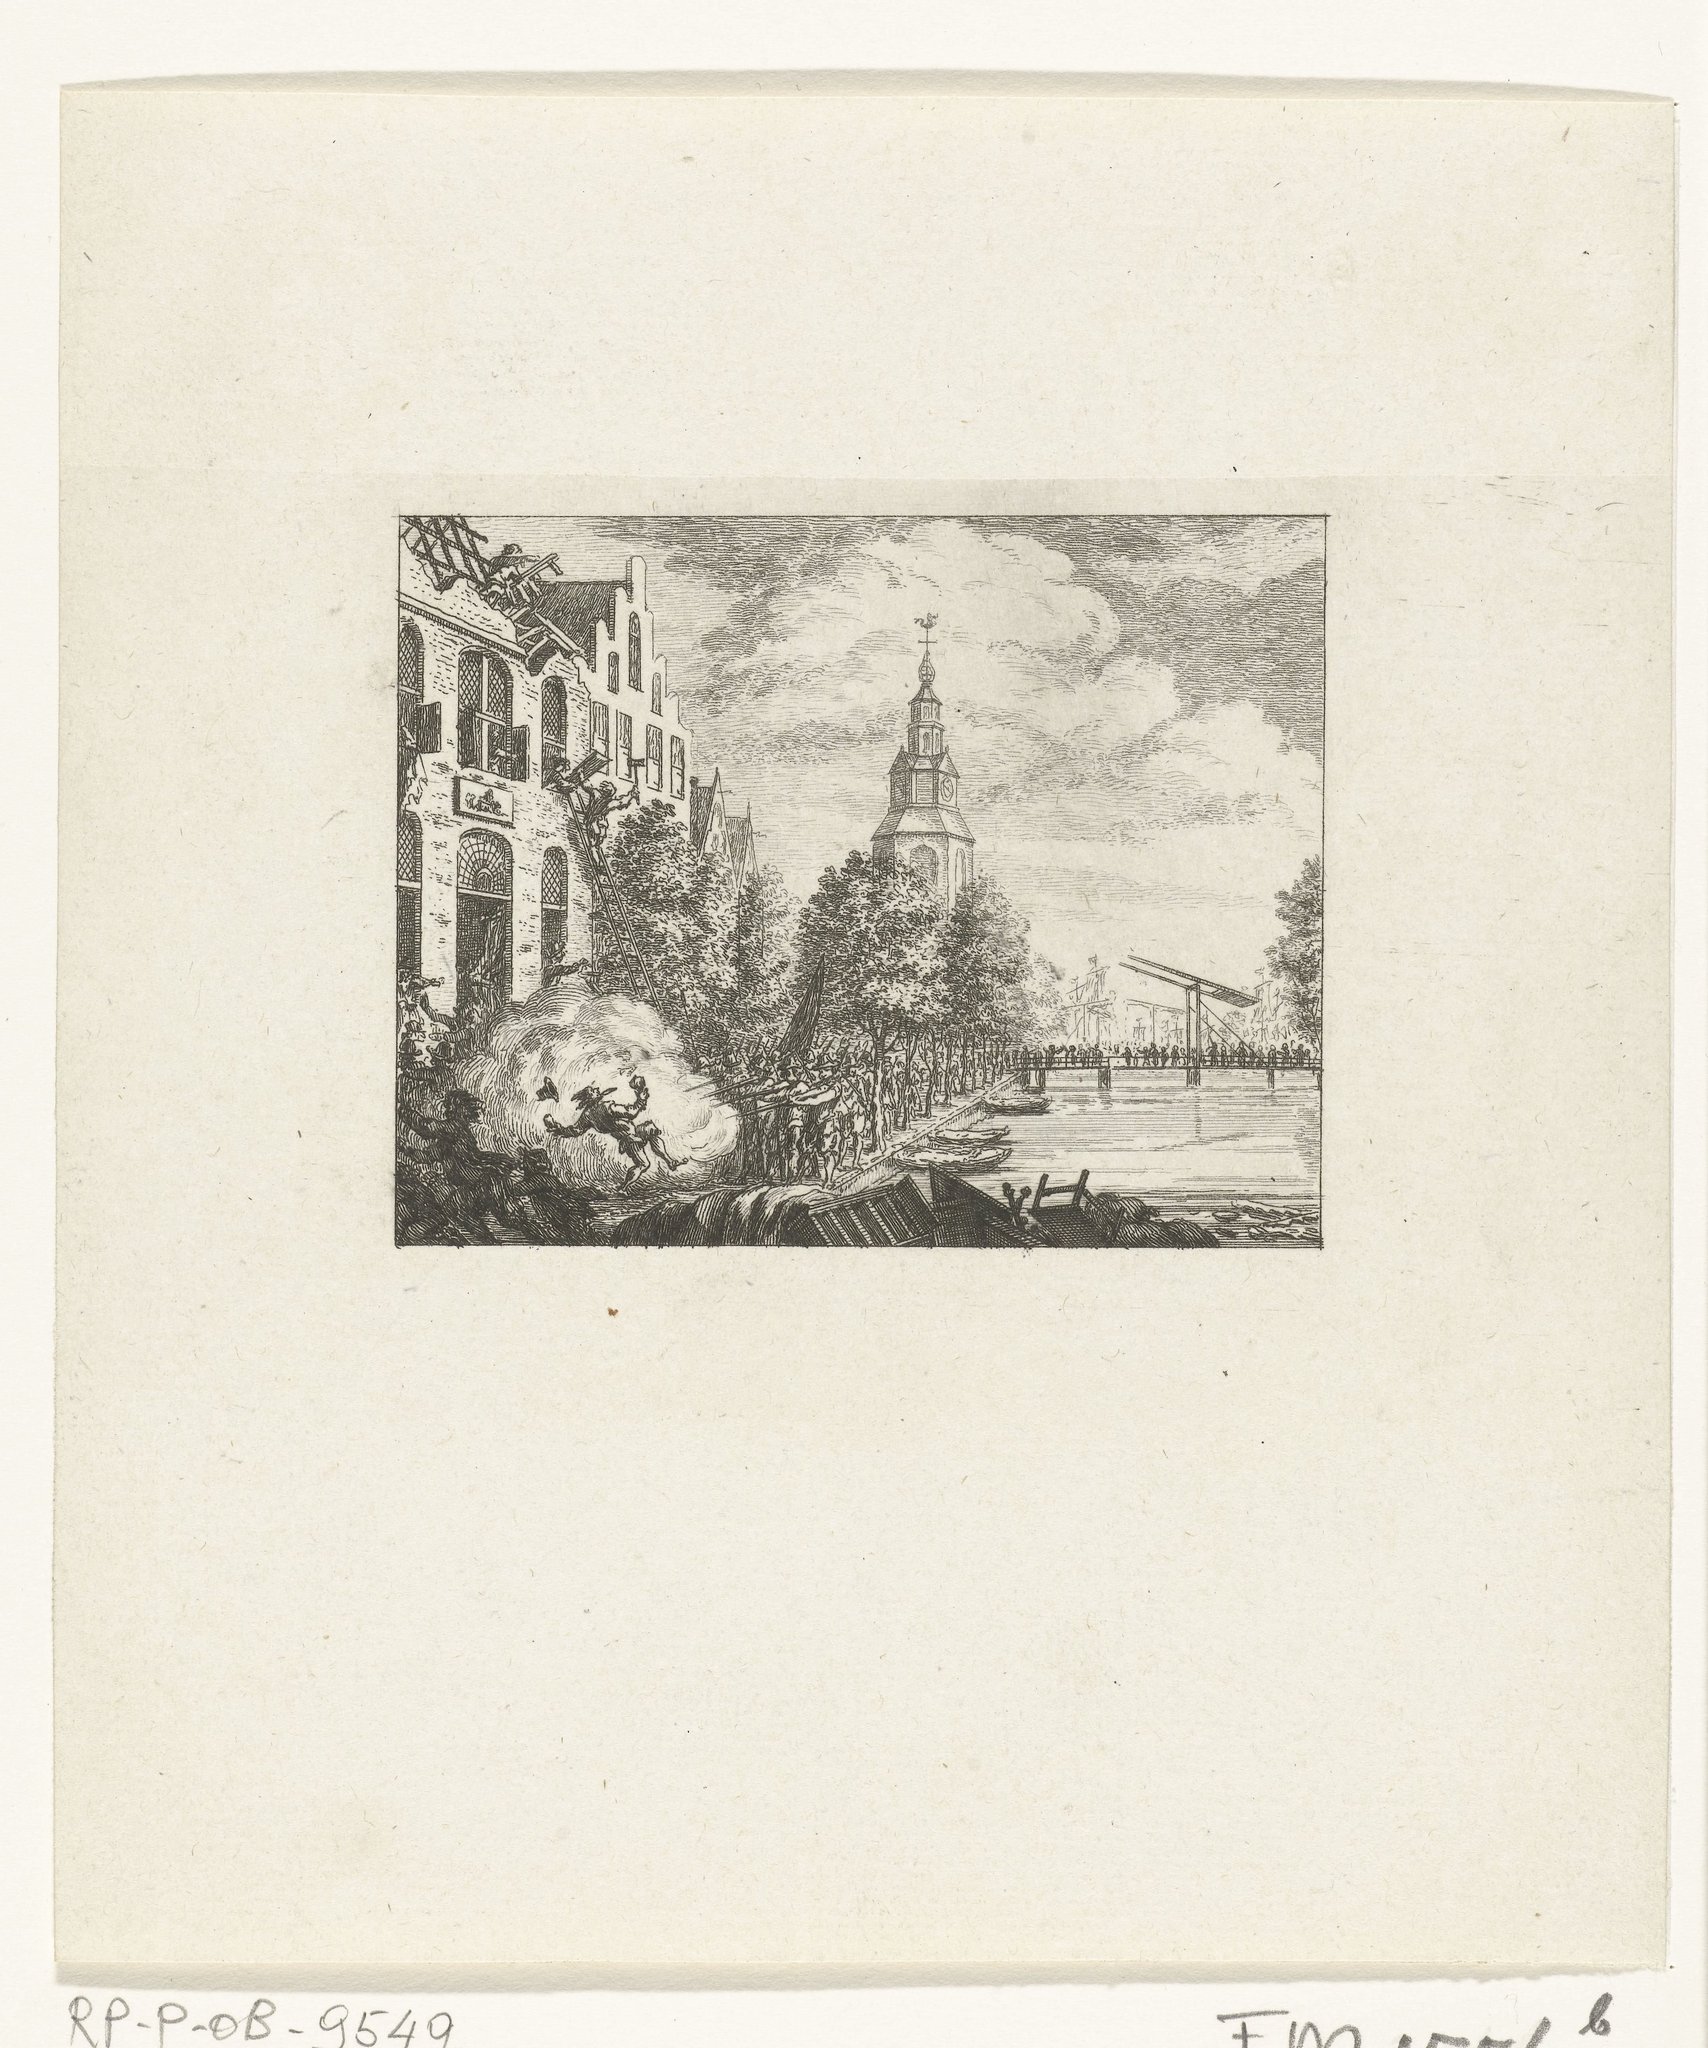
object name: history print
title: Plundering van een Remonstrantse kerk op de Oude Schans, 1626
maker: simon fokke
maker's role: draughtsman, print maker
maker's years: 1712-1784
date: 1779-1781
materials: paper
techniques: etching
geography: northern netherlands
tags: plundering ~ riot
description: Volgens de catalogus van de Atlas van Stolk onderdeel van een serie van 7 prentjes van straatoproer te Amsterdam, in 1781 verschenen. Dit exemplaar waarschijnlijk niet verworven met de collectie Muller in 1881.